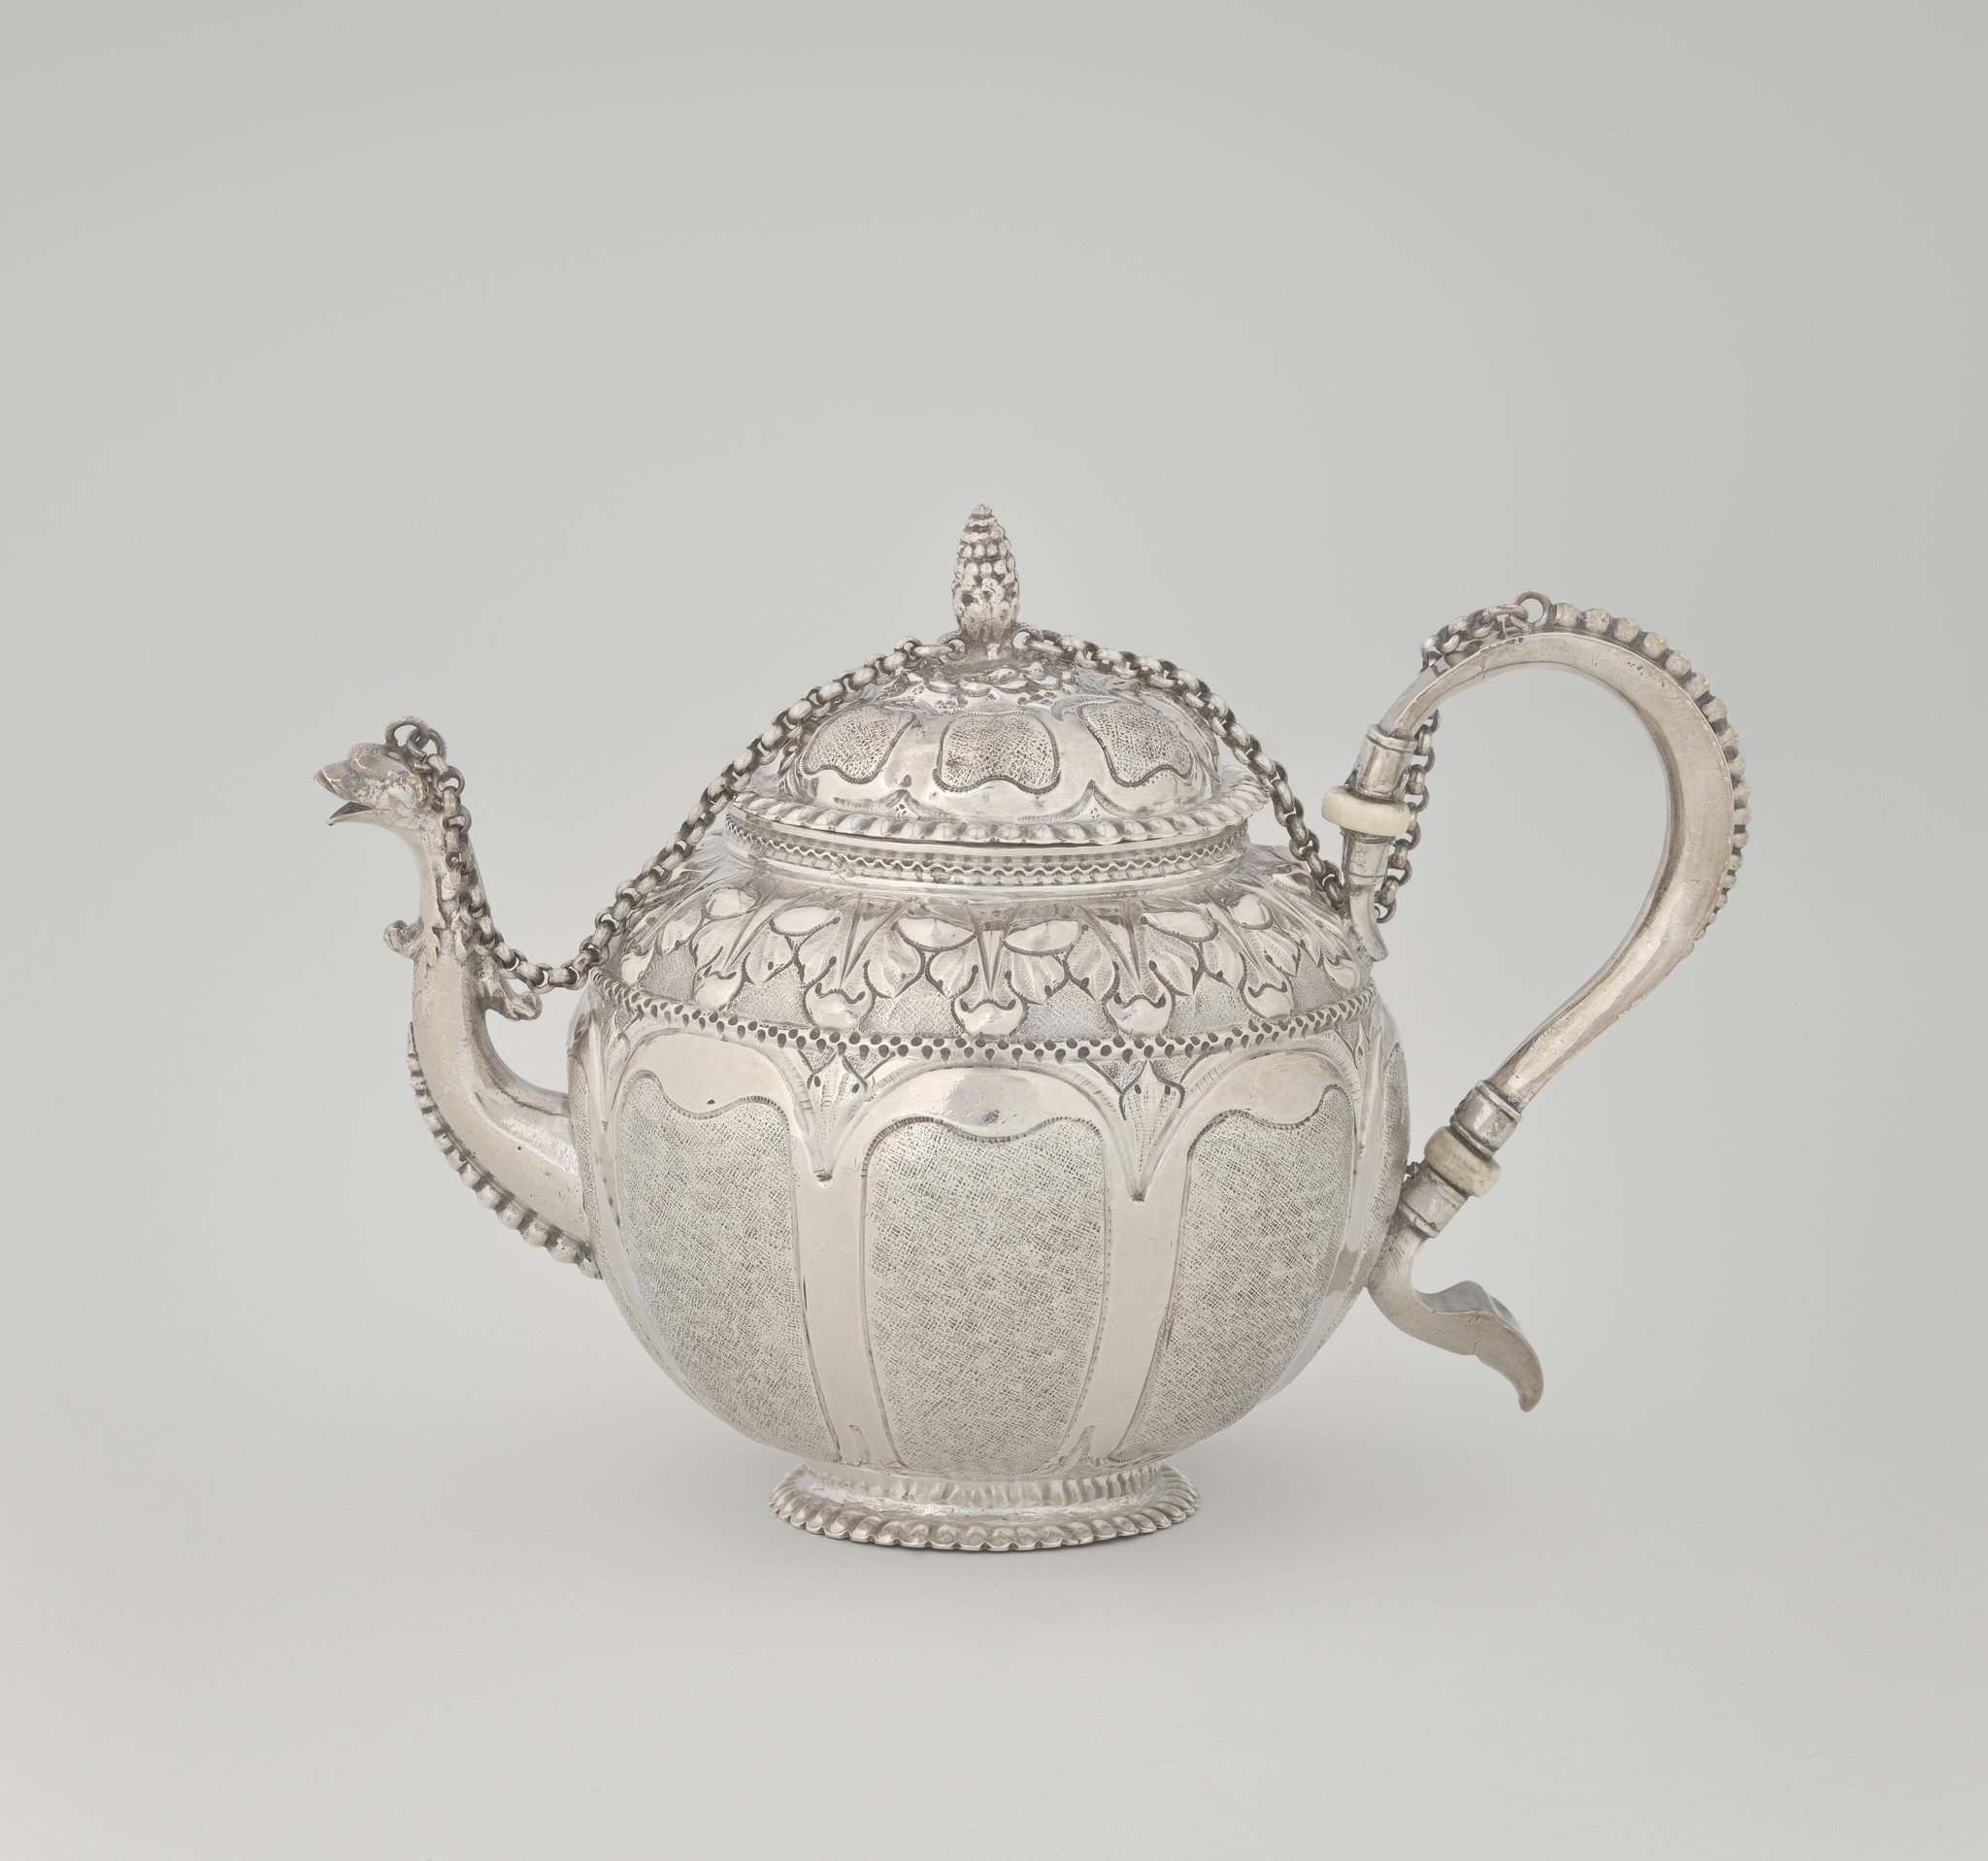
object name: teapot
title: Trekpot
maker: Anonymous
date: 1721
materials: ivory, silver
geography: amsterdam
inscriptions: maker's mark: ‘IDV?’, : ‘I = belastingteken 1795 voor Enkhuizen’, mark: ‘stadskeur Amsterdam, Hollandse leeuw, jaarletter L = 1697 of 1721’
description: De ronde pot rust op een holle, met parelranden versierde standring, en heeft een bol lichaam, aan de bovenzijde afgesloten door een rechte rand. Smalle randen verdelen de versiering op het lichaam in friezen ; onder worden grote lobben gecombineerd met bladmotieven, boven een golvende band zijn bladmotieven aangebracht. De golvende band wordt herhaald op de rechte rand. Op het bol gewelfde deksel worden de lobben herhaald, de uitstekende rand is met parels versierd. Het geheel wordt bekroond door een rozet met daarboven een dennenappel. Het recht uitstaande S-vormige oor bestaat uit drie verschillende delen, die onderling door zilveren manchetten en ivoren ringen worden gescheiden. De S-vormige tuit eindigt in een door bladmotieven gevormde drakenkop. Beide elementen zijn versierd met parels in aflopende grootte. Zij worden onderling verbonden door een schakelketting.